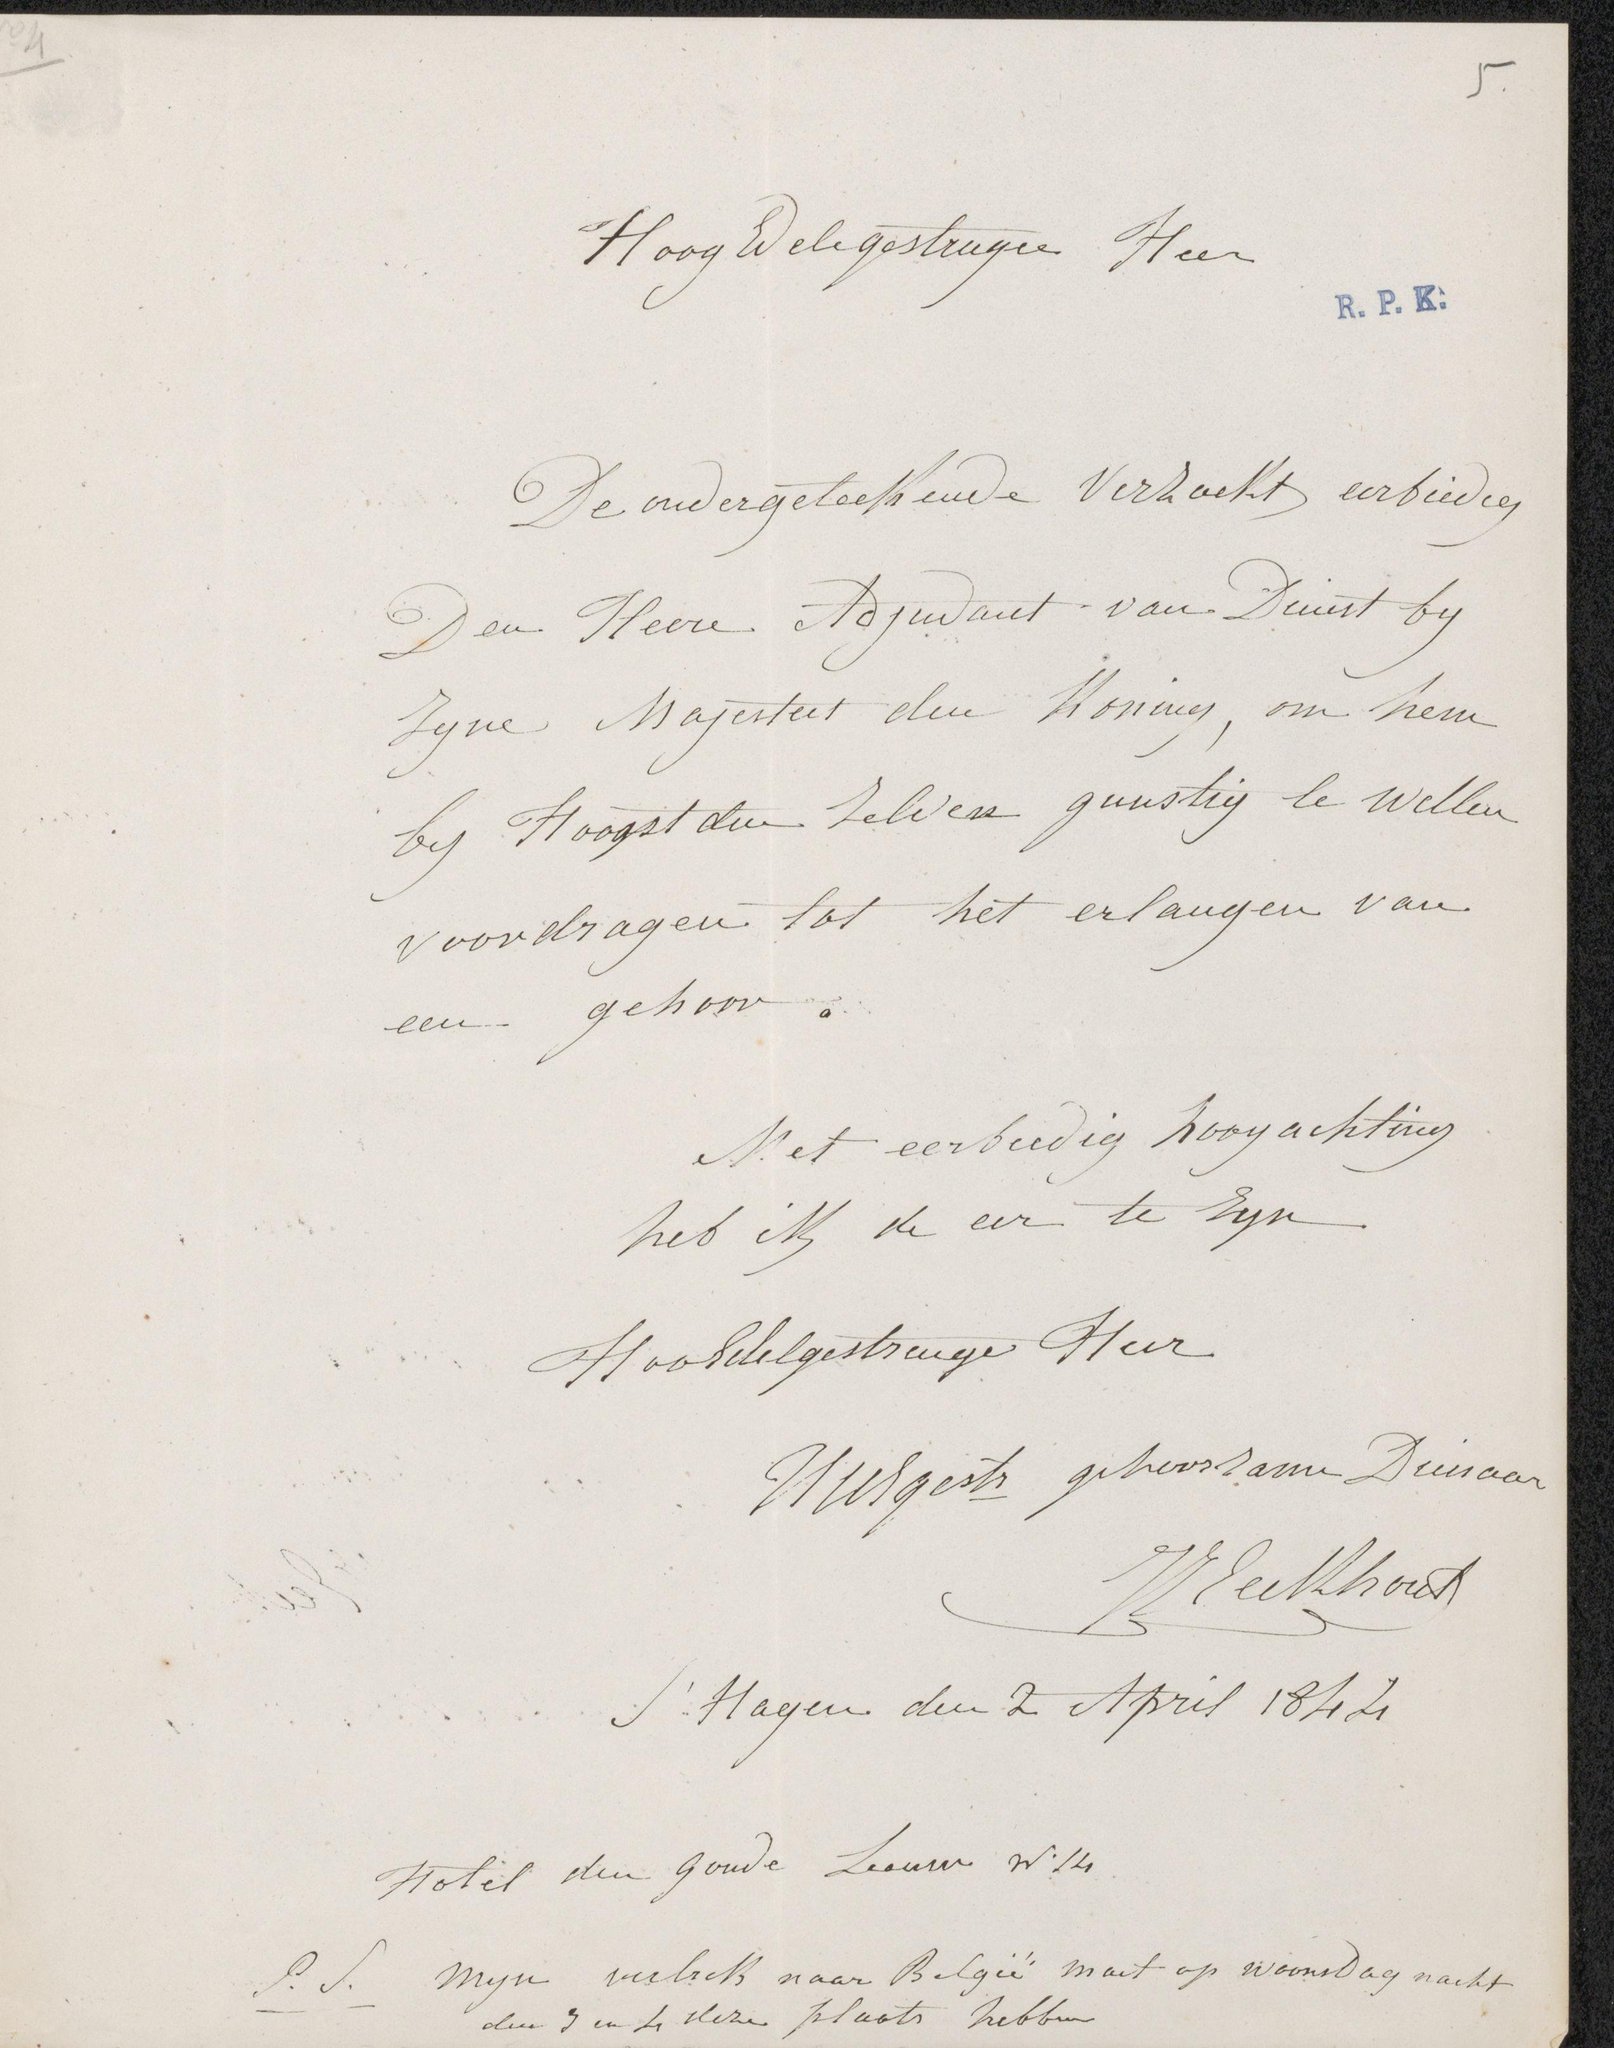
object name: letter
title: Brief aan anoniem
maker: jacob joseph eeckhout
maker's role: draughtsman, print maker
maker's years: 1793-1861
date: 1844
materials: ink, paper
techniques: pen, writing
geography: the hague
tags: william ii of the netherlands, belgium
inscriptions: collector's mark: Lugt 2233